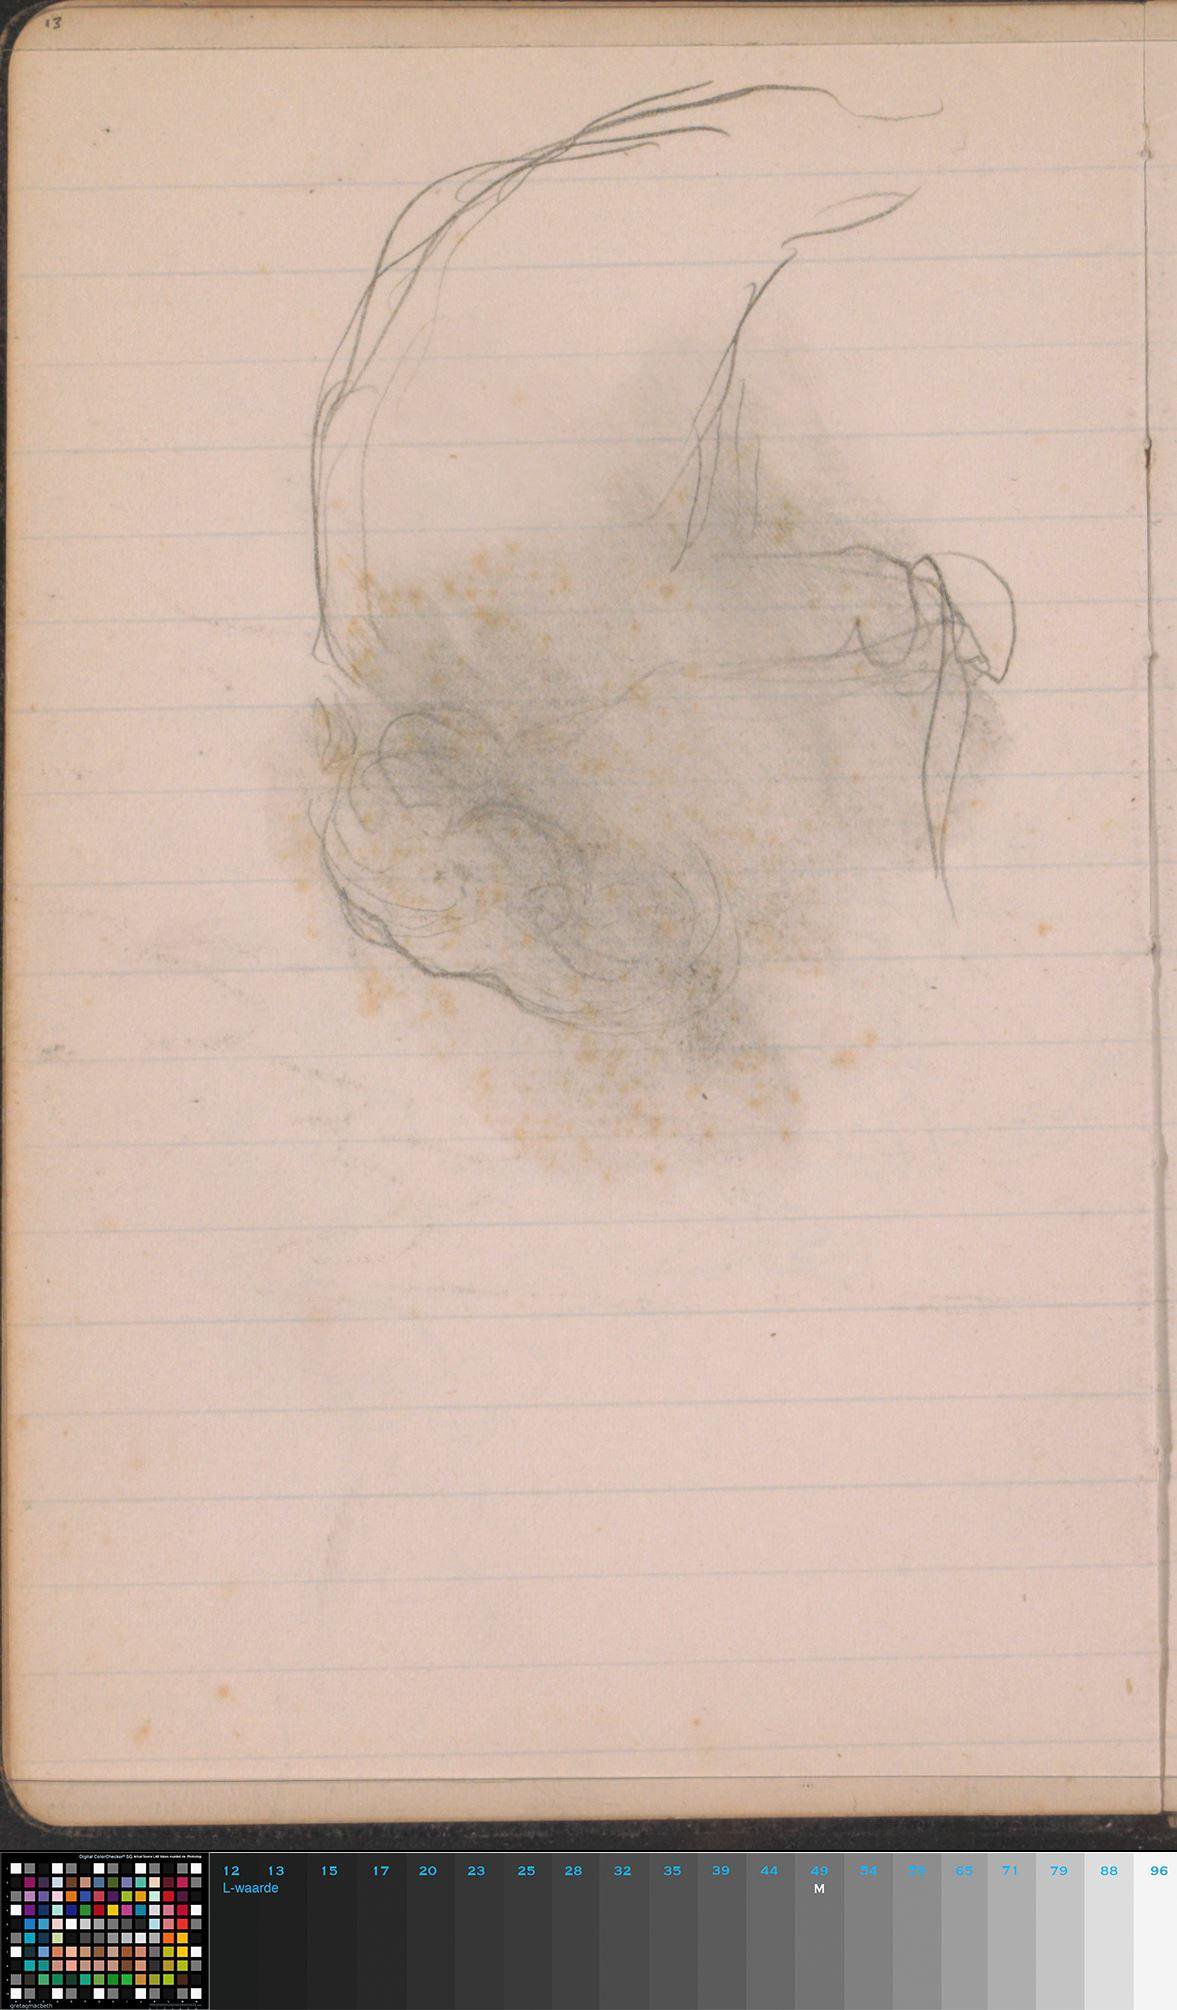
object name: sketchbook leaf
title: Olifant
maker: marius bauer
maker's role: draughtsman, print maker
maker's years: 1867-1932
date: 1897-1898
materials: pencil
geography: india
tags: trunked animals: elephant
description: Pagina 13 uit een schetsboek met 84 bladen.